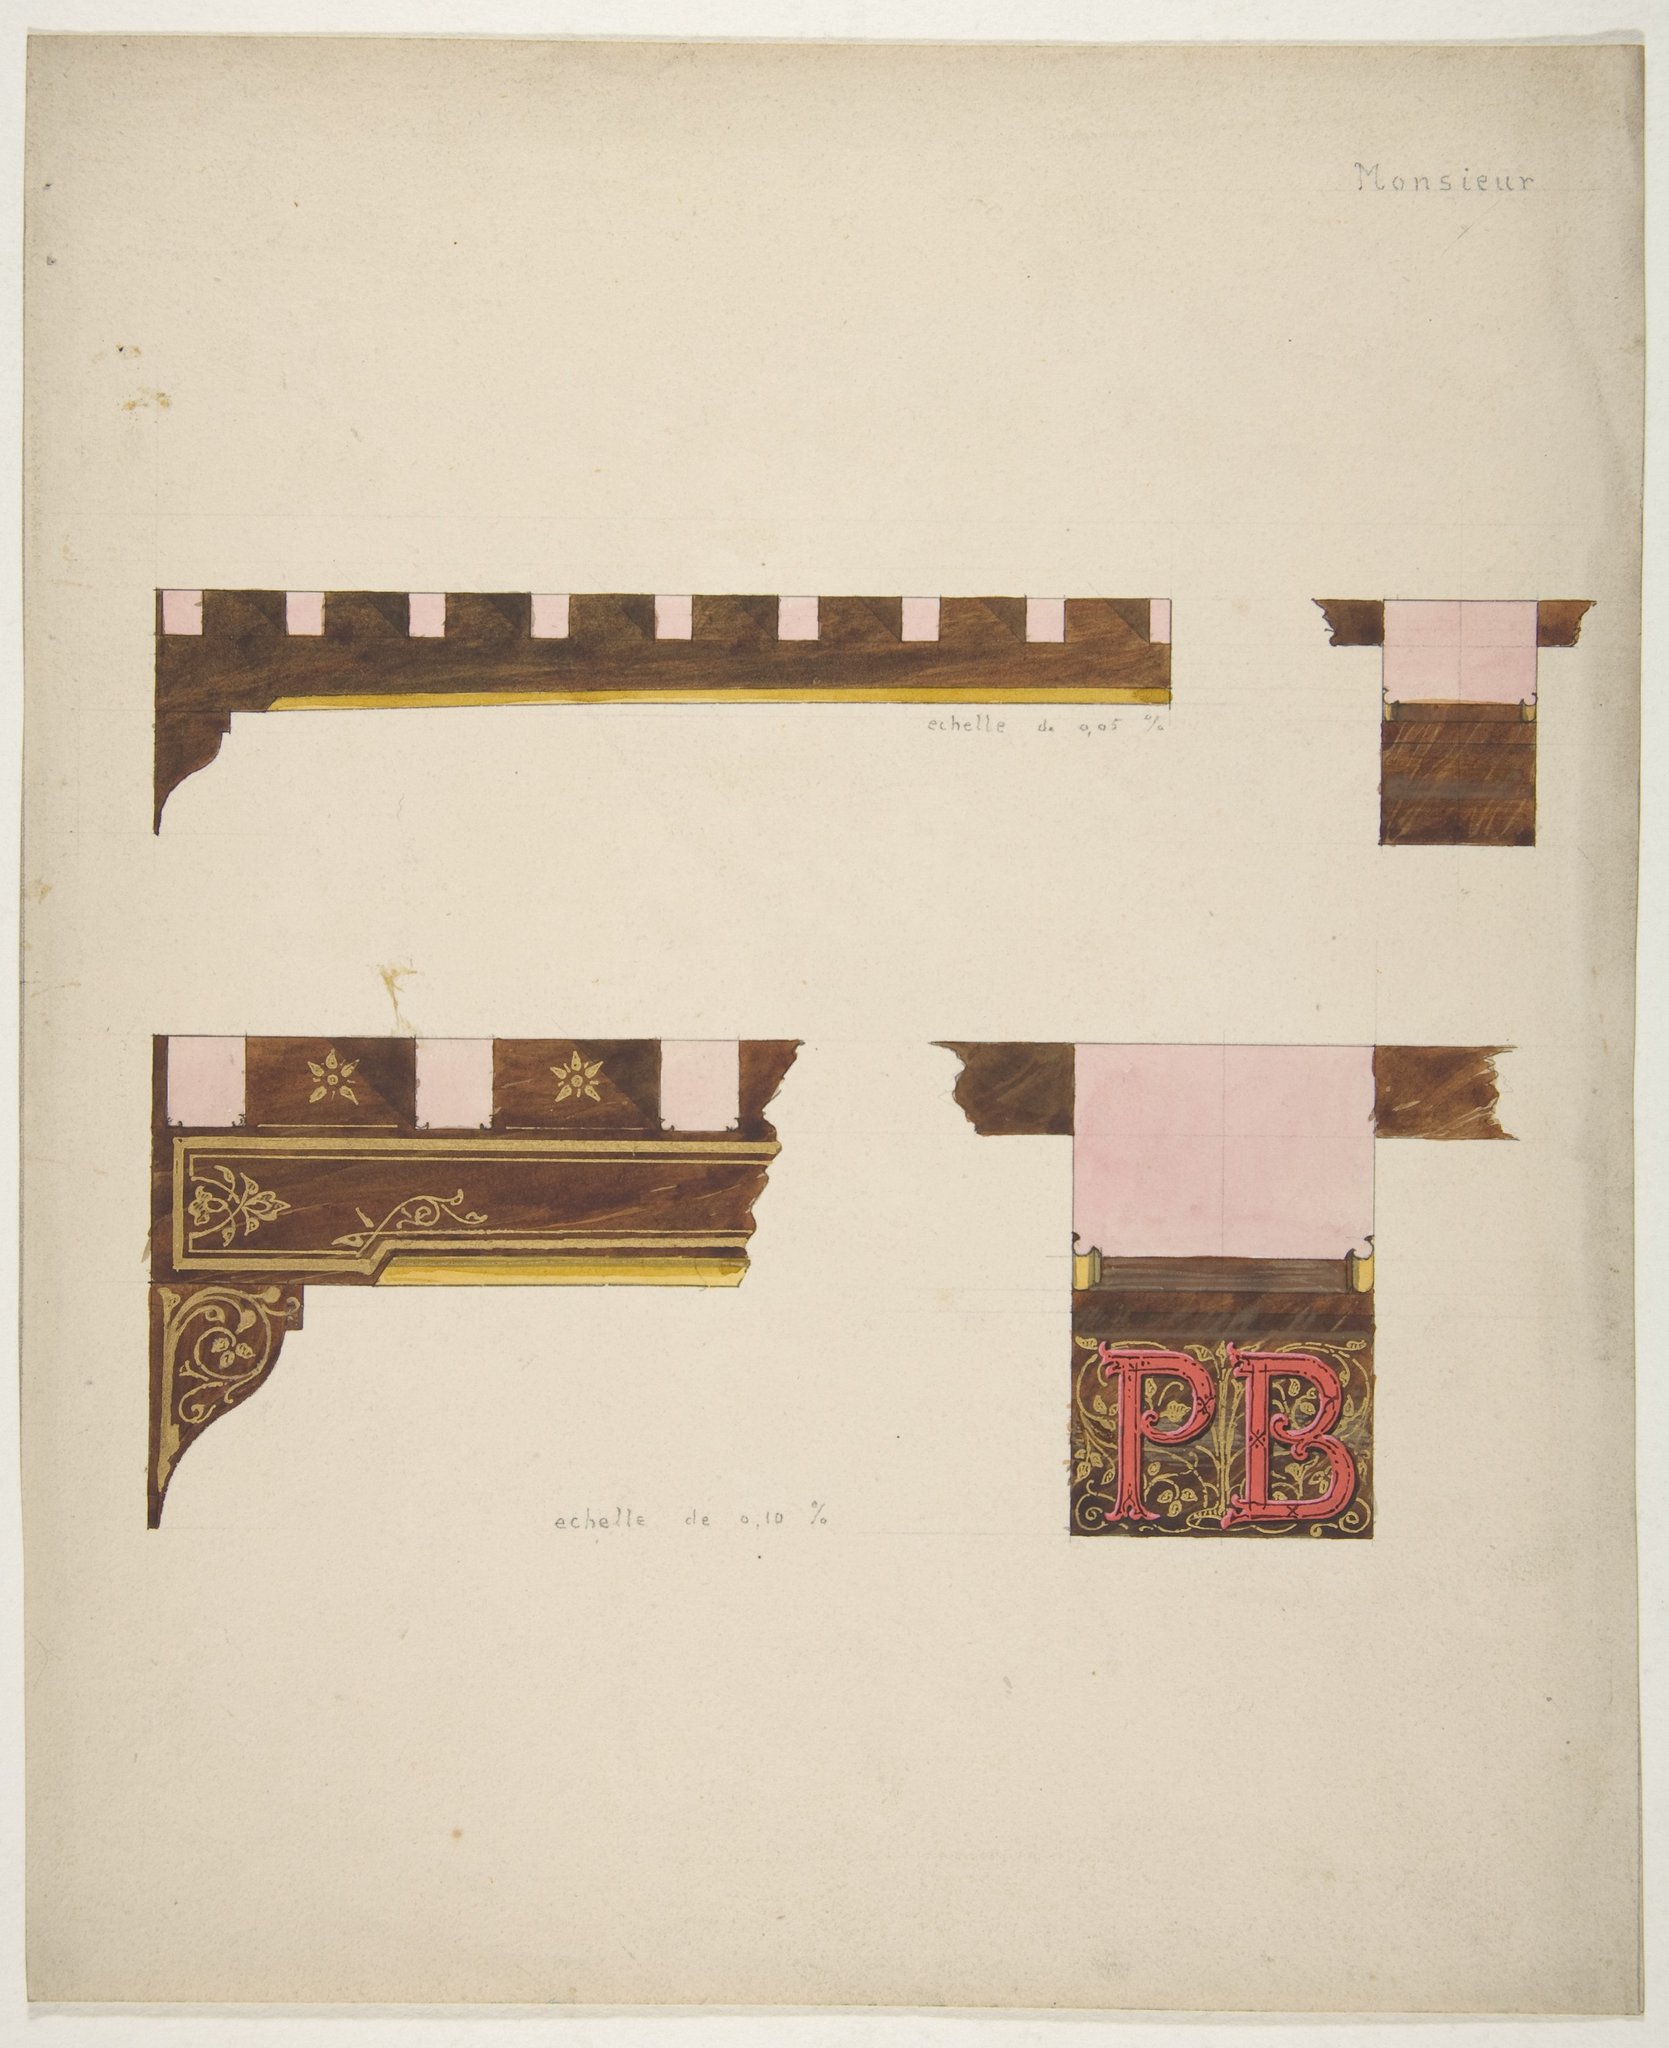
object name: drawing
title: Designs for the painted decoration of ceiling timbers monogrammed "PB"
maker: jules-edmond-charles lachaise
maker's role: artist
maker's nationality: french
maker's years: 1897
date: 1851-1900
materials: gold paint, ink, watercolor, paper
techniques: pen